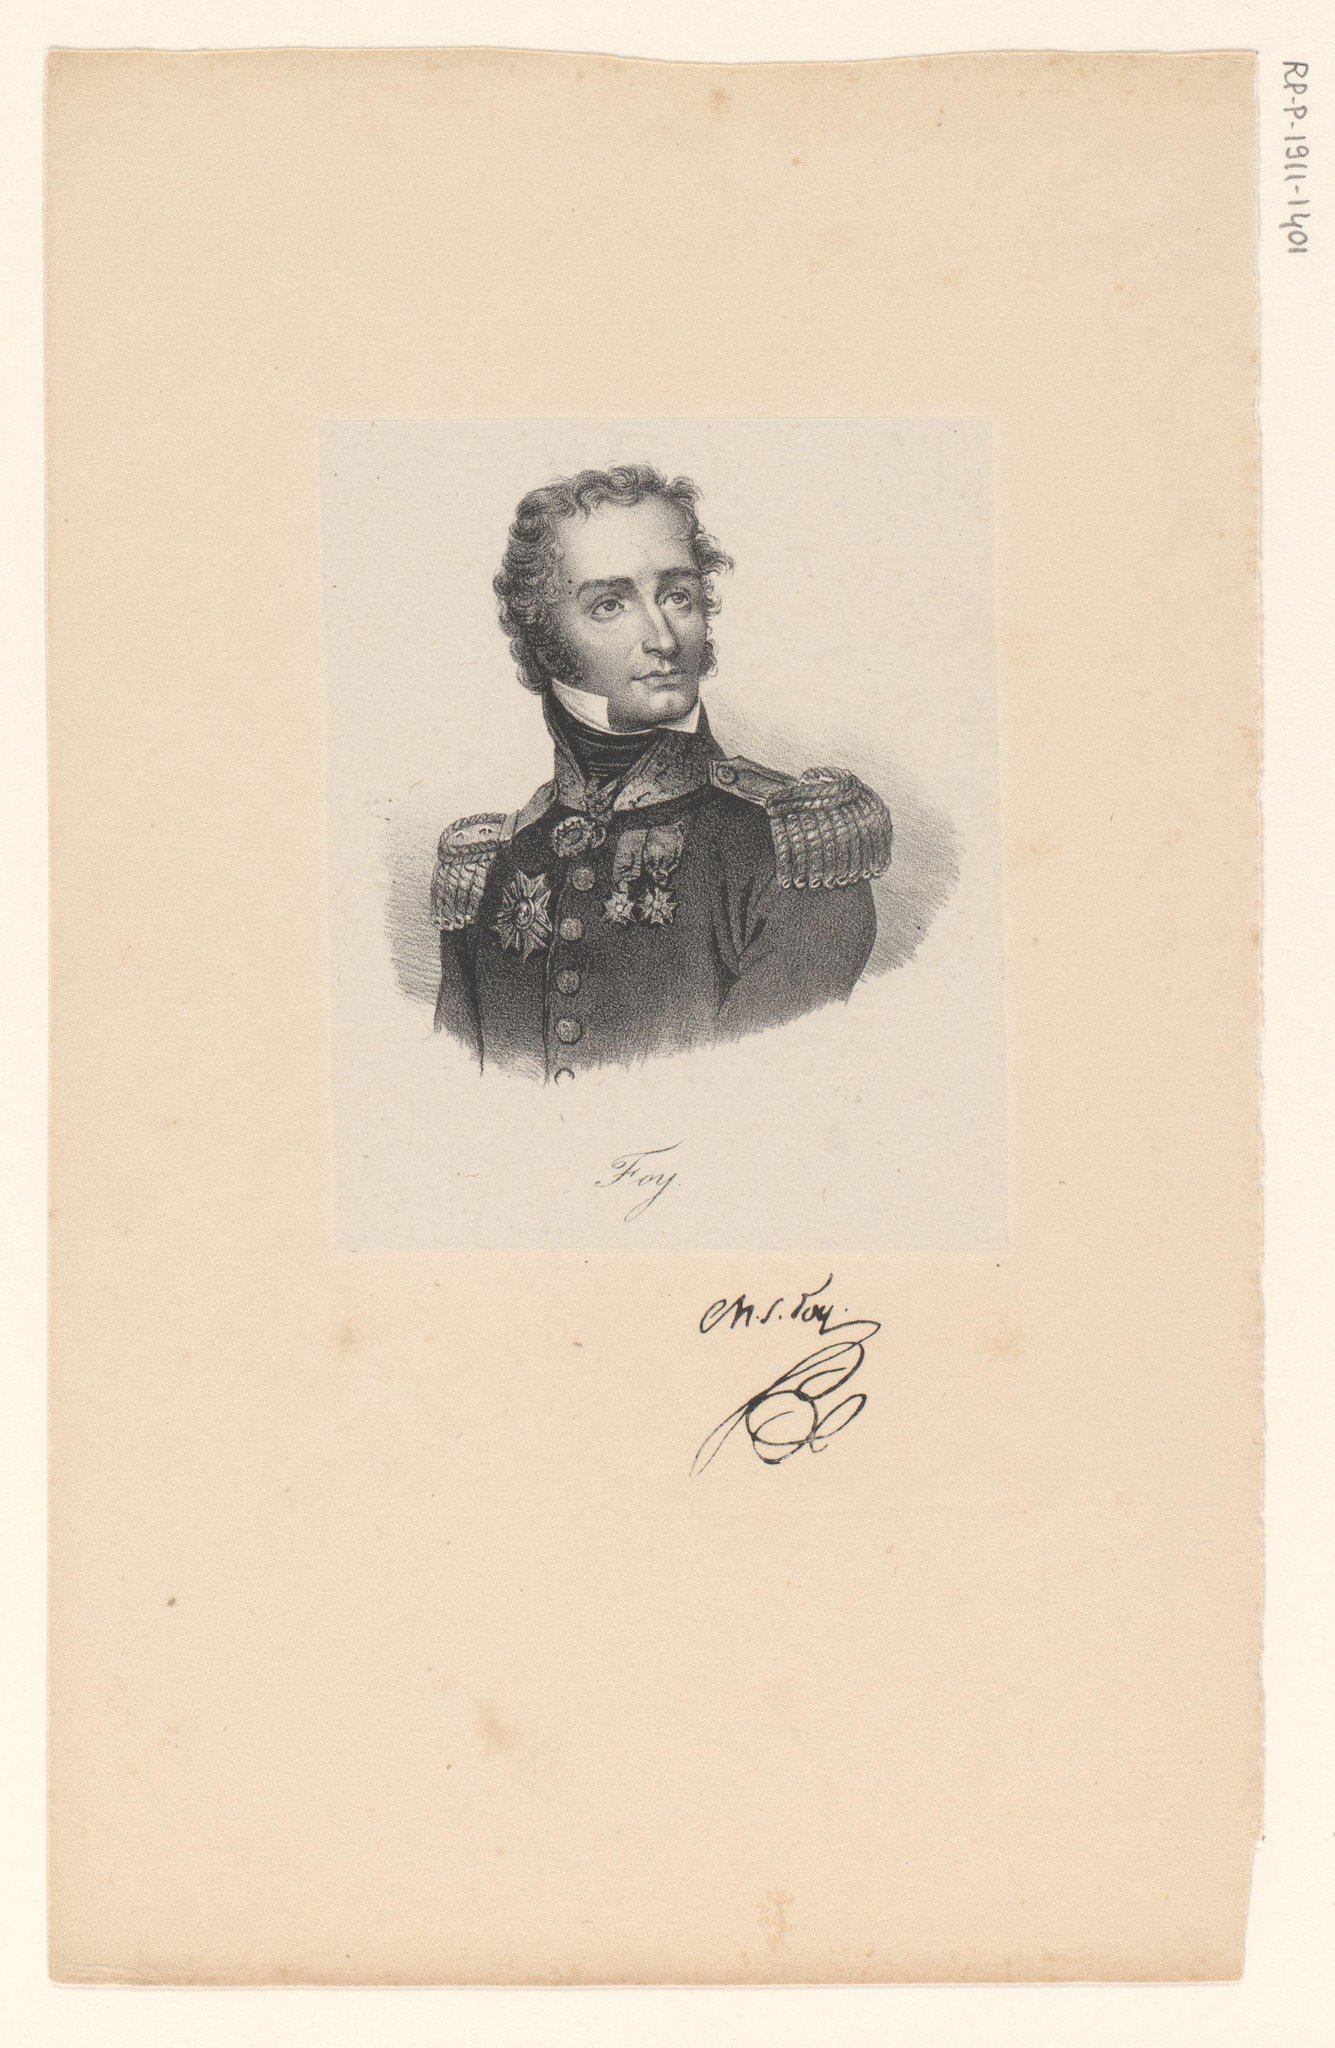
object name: print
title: Foy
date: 1818-1842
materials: paper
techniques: lithograph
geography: paris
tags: paris, politician, maximilien sébastien foy, historical persons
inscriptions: collector's mark: Lugt 2228a